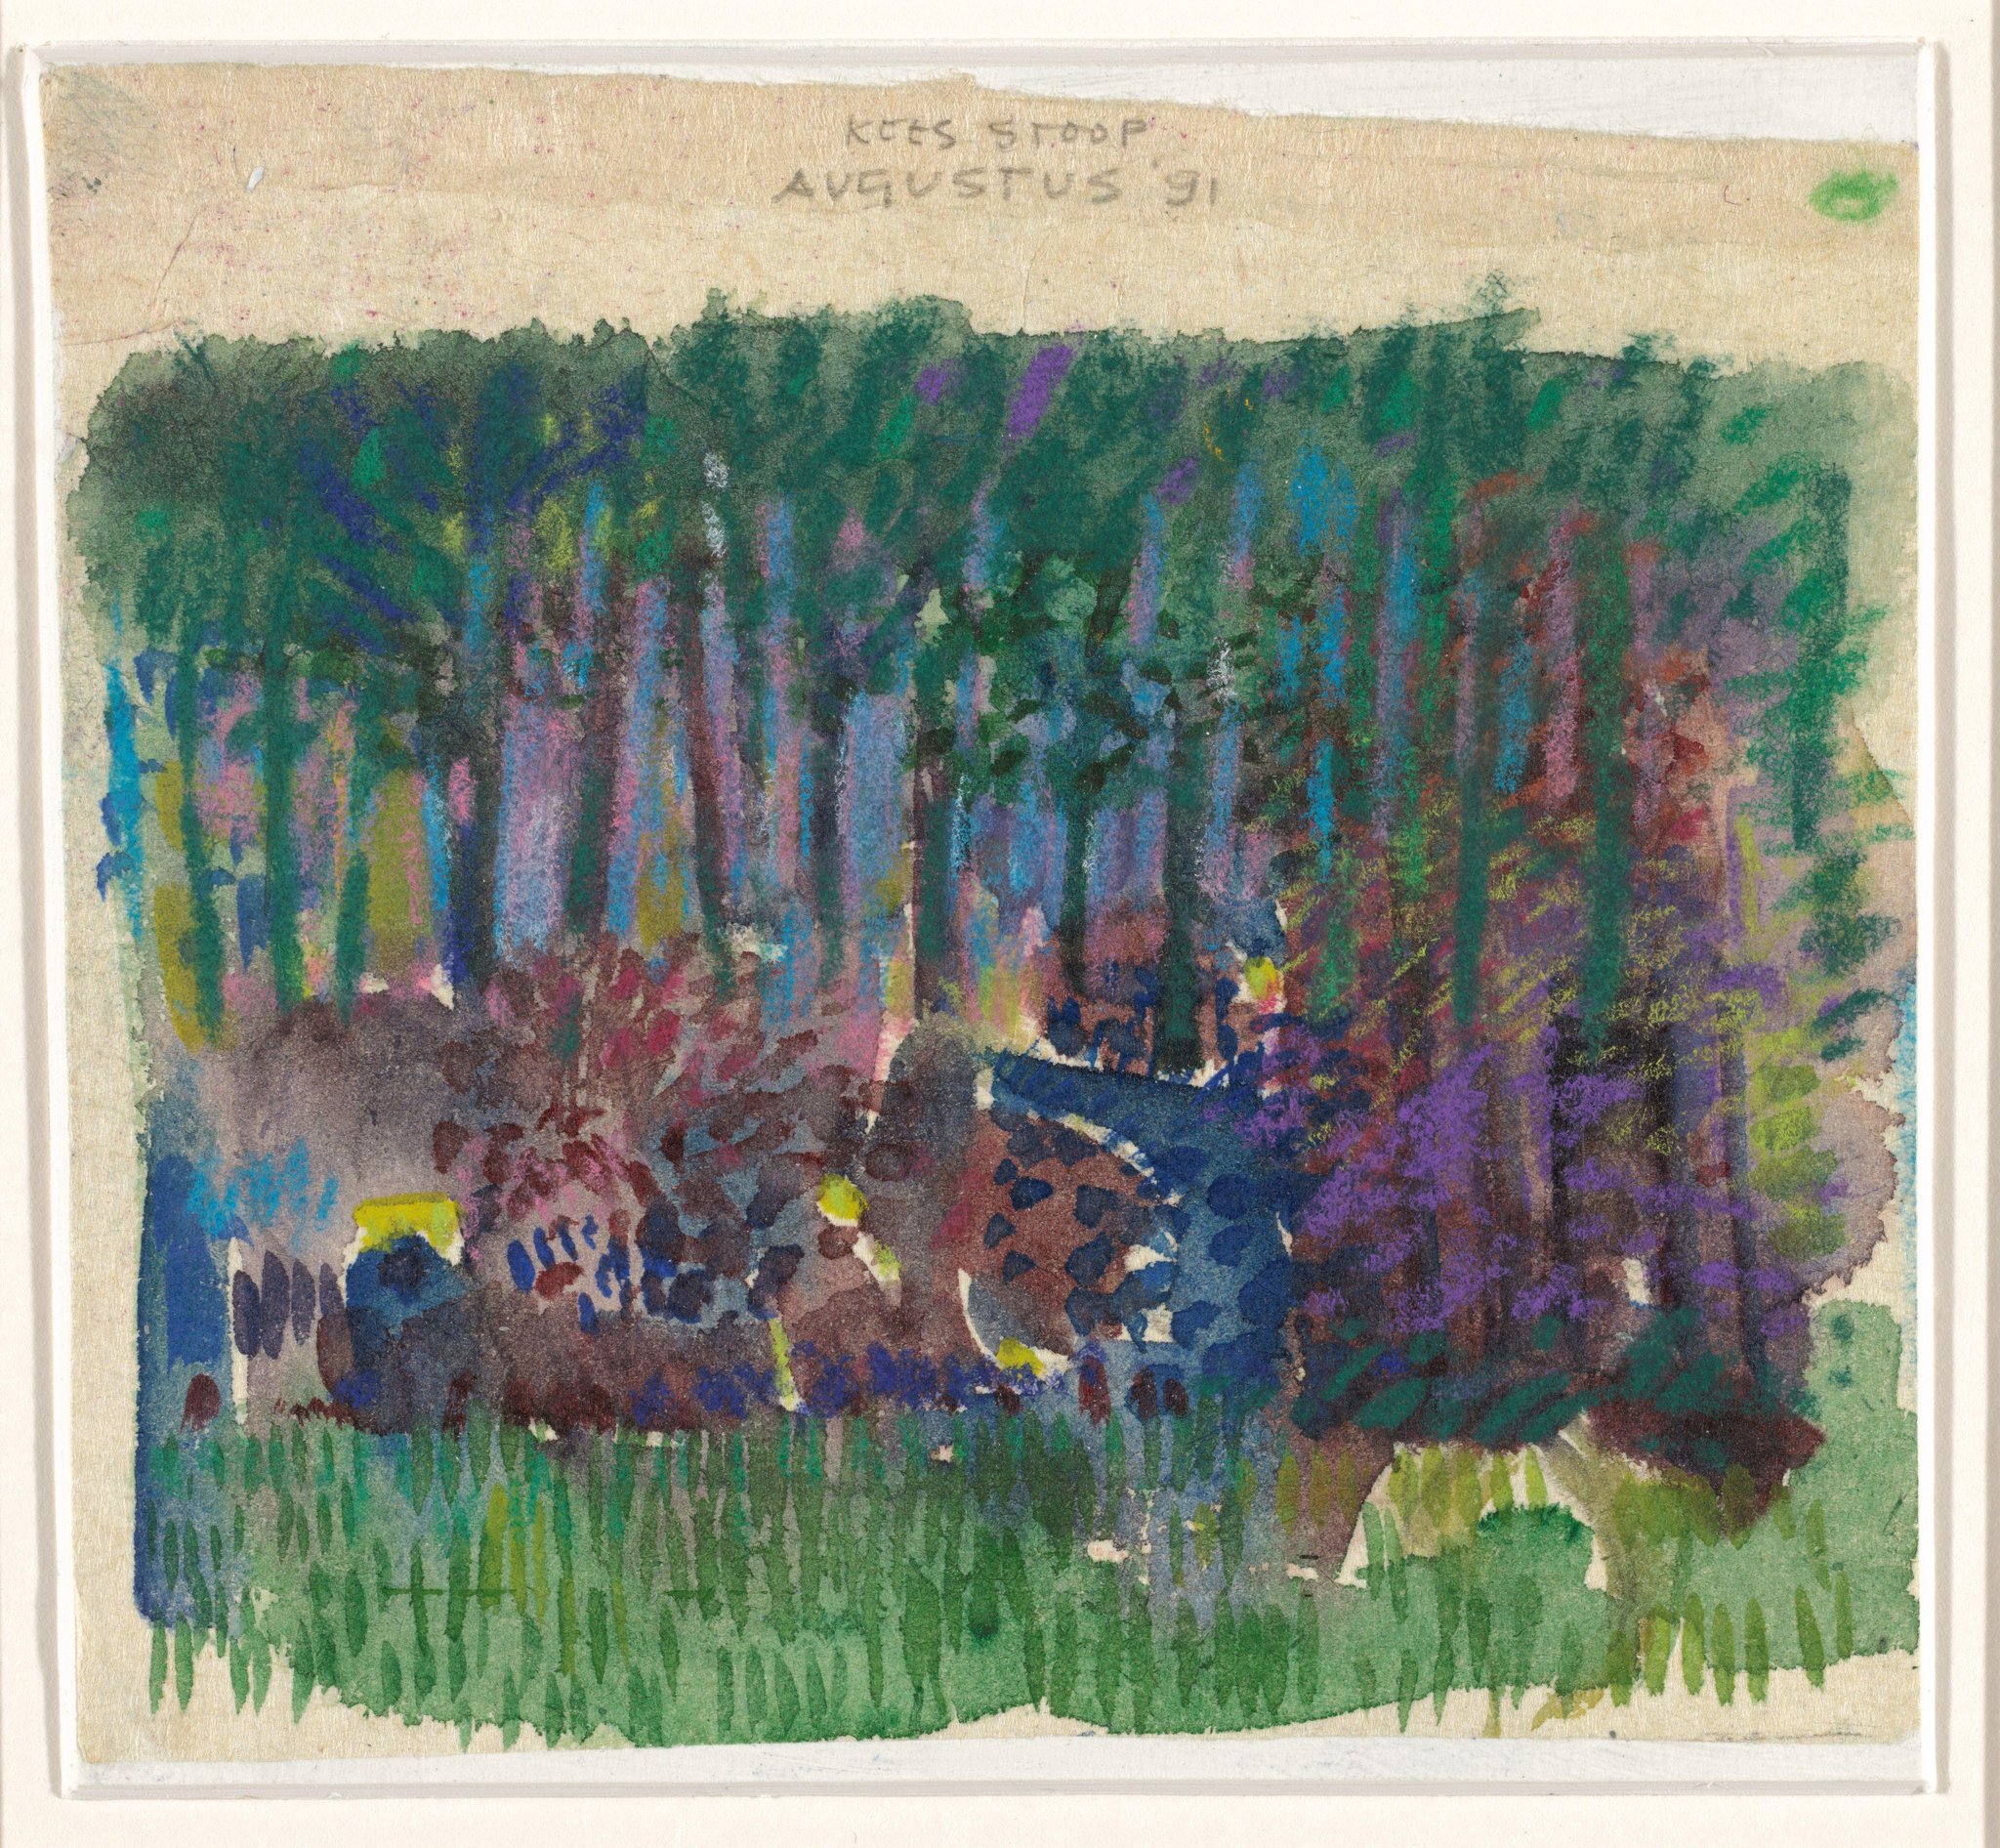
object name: drawing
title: Bosrand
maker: kees stoop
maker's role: draughtsman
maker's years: 1929-2019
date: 1908-1991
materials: paper, watercolor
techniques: brush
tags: groups of trees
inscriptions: signature and date: ‘KEES STOOP / AUGUSTUS '91’